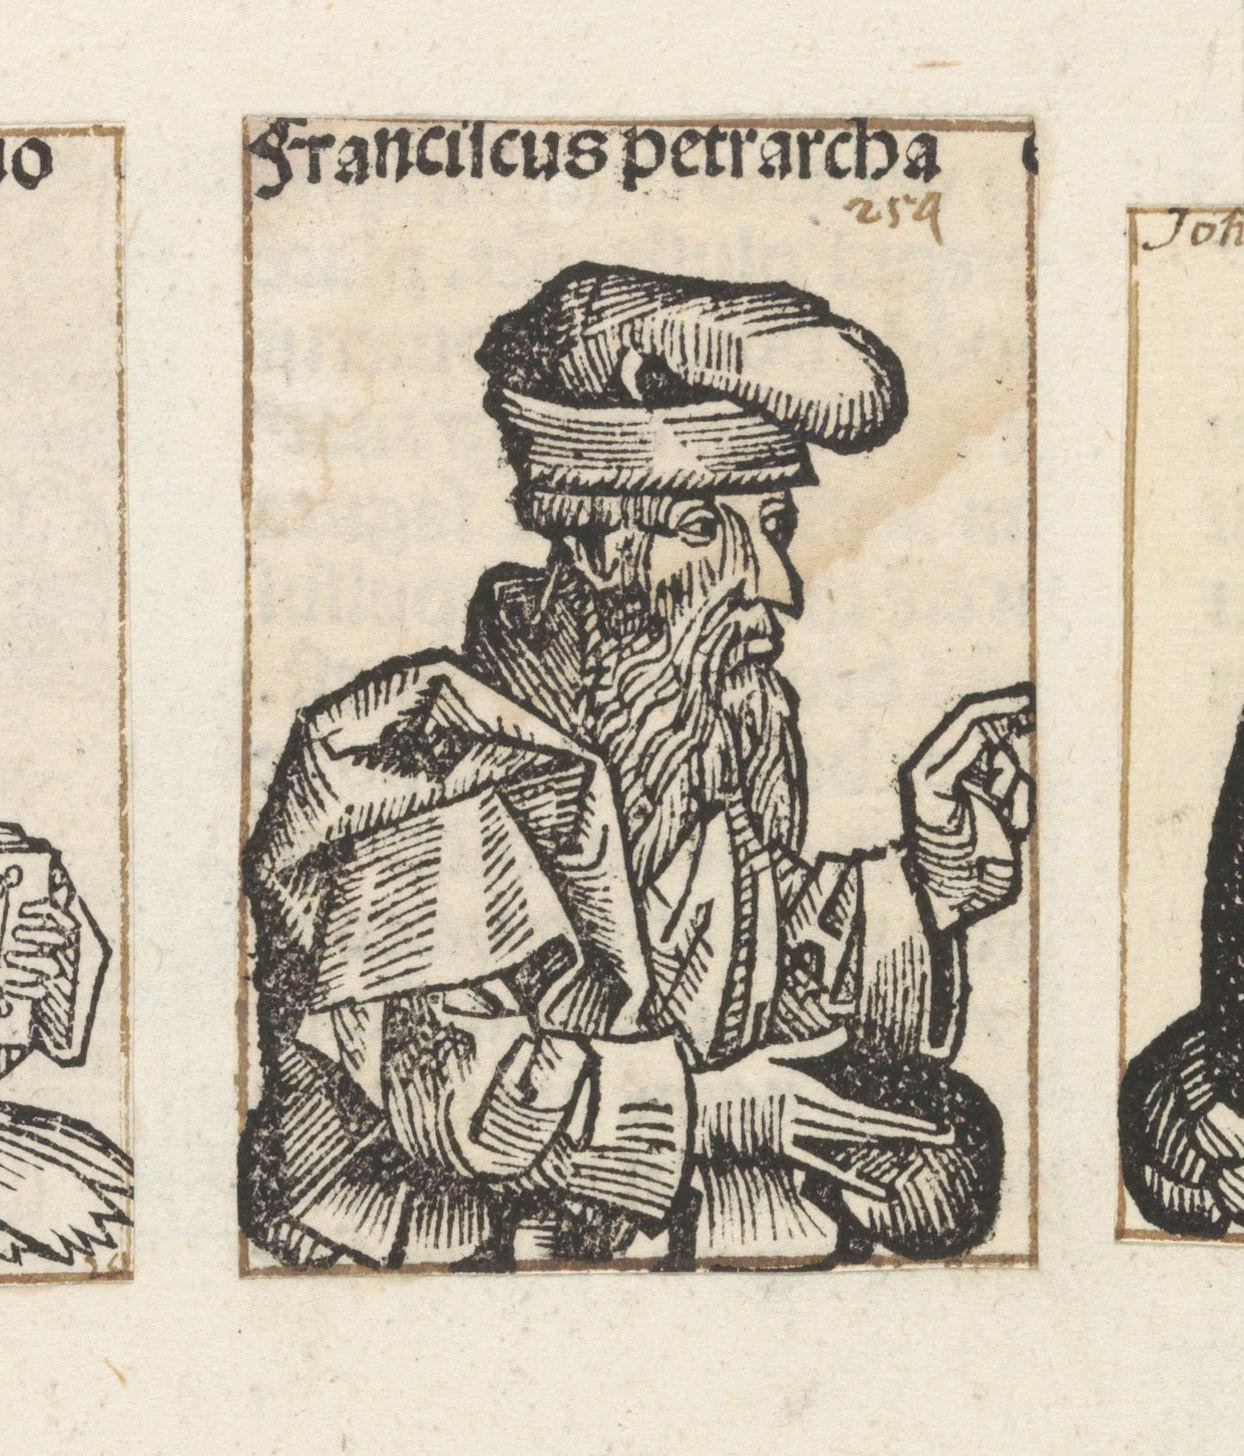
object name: album leaf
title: Franciscus petrarcha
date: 1493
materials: paper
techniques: letterpress printing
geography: nuremberg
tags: francesco petrarca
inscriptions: inscription: ‘254’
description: De houtsnede wordt herhaaldelijk gebruikt als boekillustratie in de Liber Chronicarum (of Neurenbergkroniek) van Hartmann Schedel, verschenen in het Latijn en Duits in 1493. Zie de Latijnse uitgave, folio 227v.